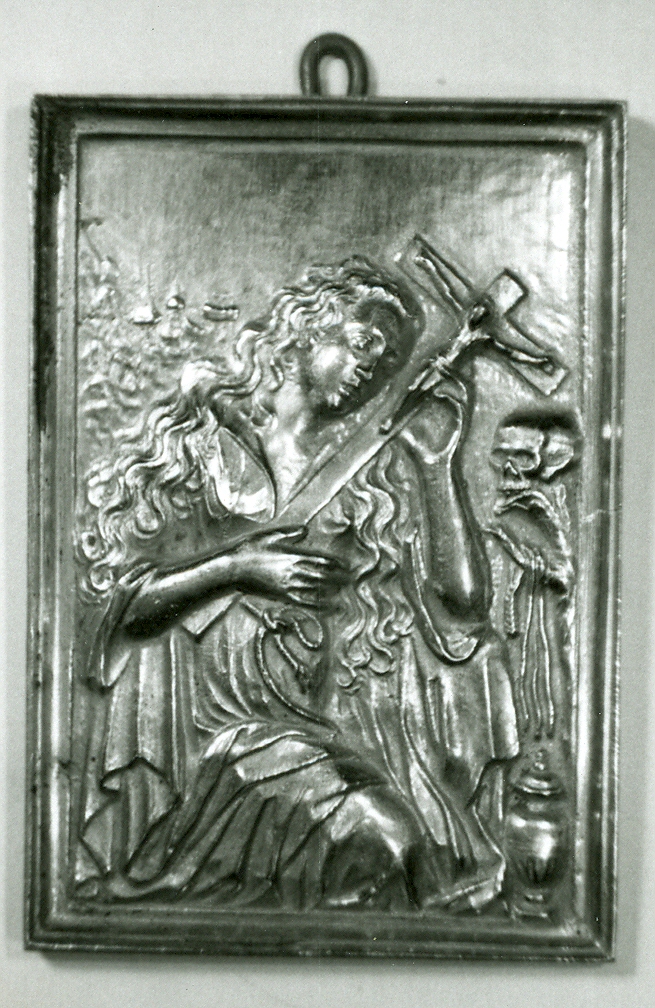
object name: plaquette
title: Mary Magdalene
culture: italian or spanish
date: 1567-1600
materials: copper alloy, gilt, patina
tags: mary magdalene